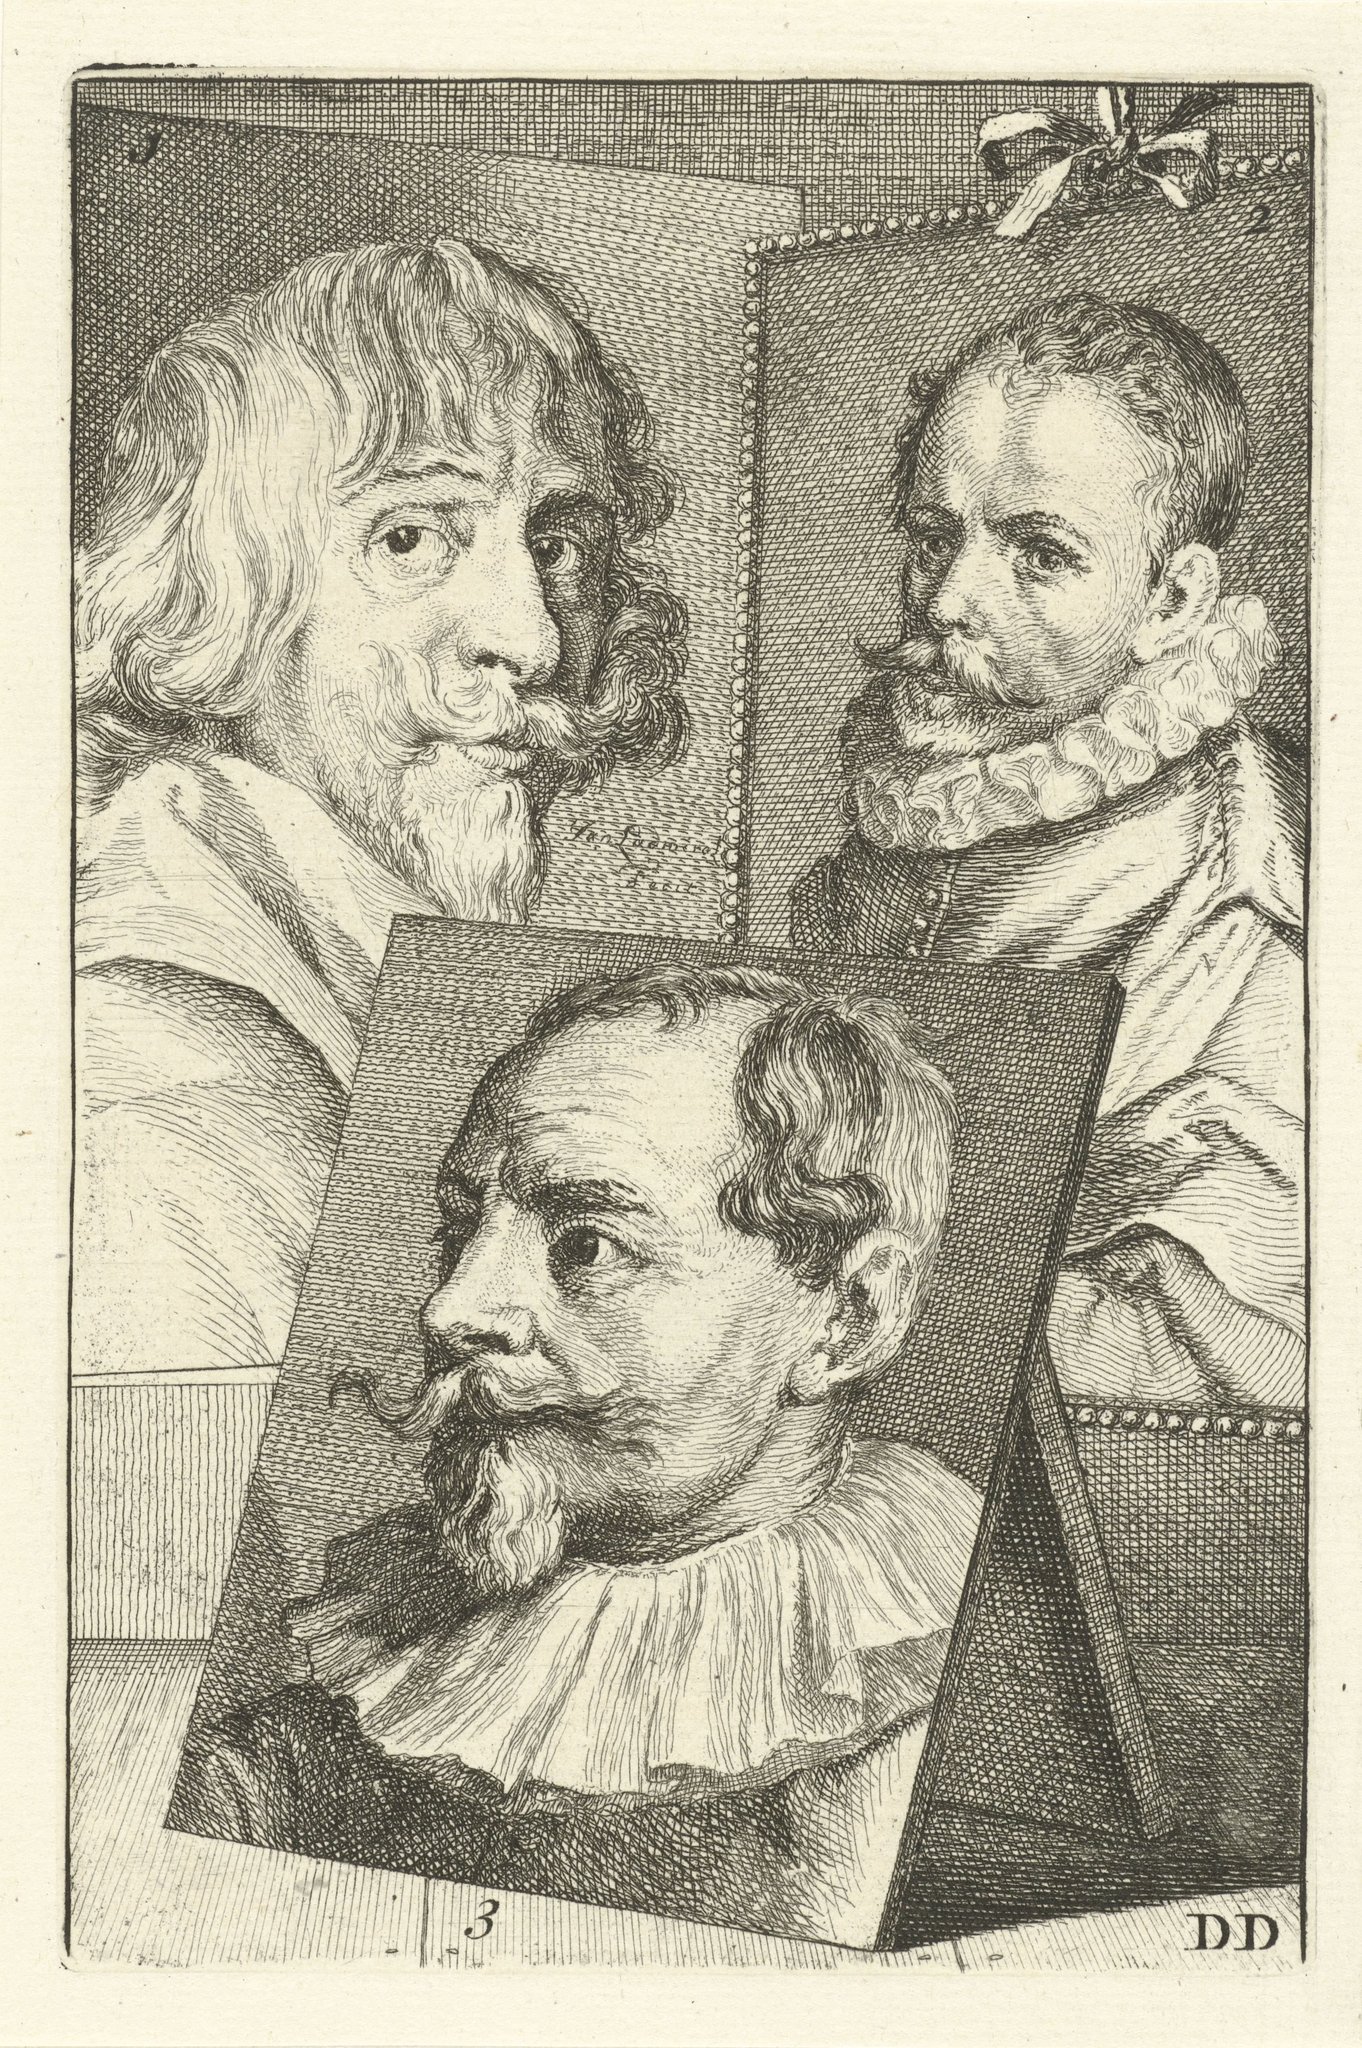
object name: print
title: Portretten van Hendrik van Steenwijck, Jacob de Gheyn en Sebastiaan Vranx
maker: jan l admiral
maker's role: draughtsman, print maker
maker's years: 1699-1773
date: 1764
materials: paper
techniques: etching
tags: antwerp, painter, print maker, draughtsman, sebastiaen vrancx, the hague, jacques de gheyn (ii), hendrik van steenwijck (ii)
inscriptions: collector's mark: Lugt 2228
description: Prent opgenomen in: Mander, Karel van; Jongh, Jacobus de (vert.). Het leven der doorluchtige Nederlandsche en eenige Hoogduitsche schilders. Amsterdam: Steven van Esveldt, 1764.